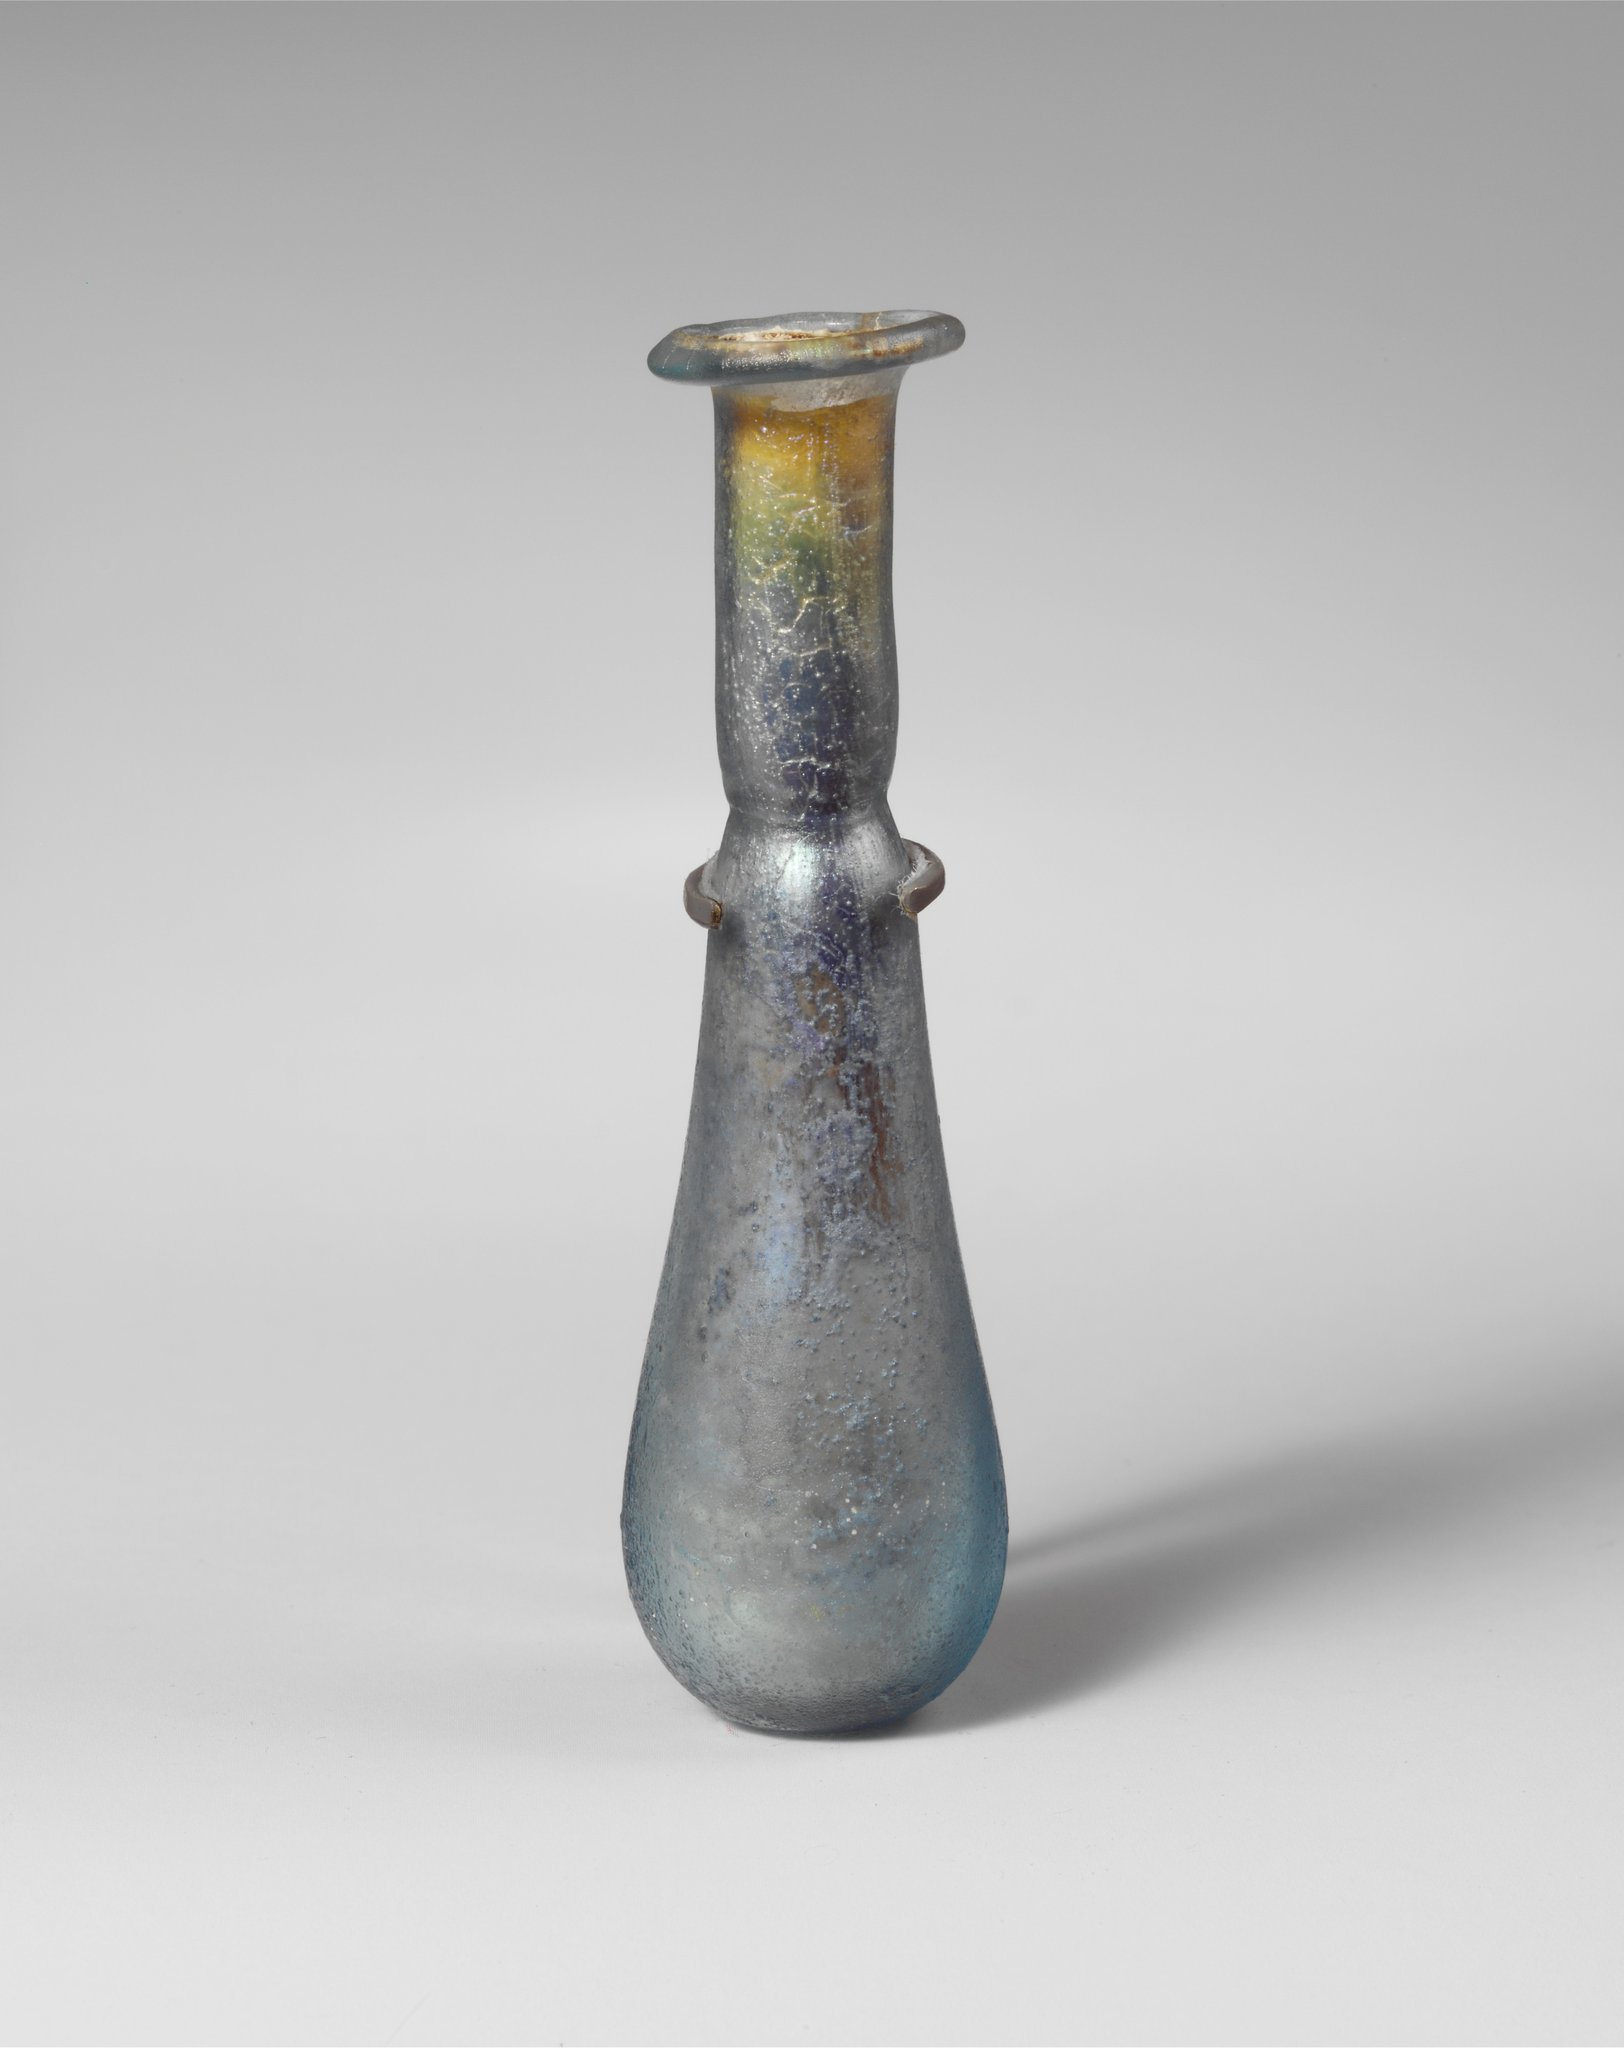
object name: perfume bottle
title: Glass perfume bottle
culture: roman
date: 1-200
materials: glass